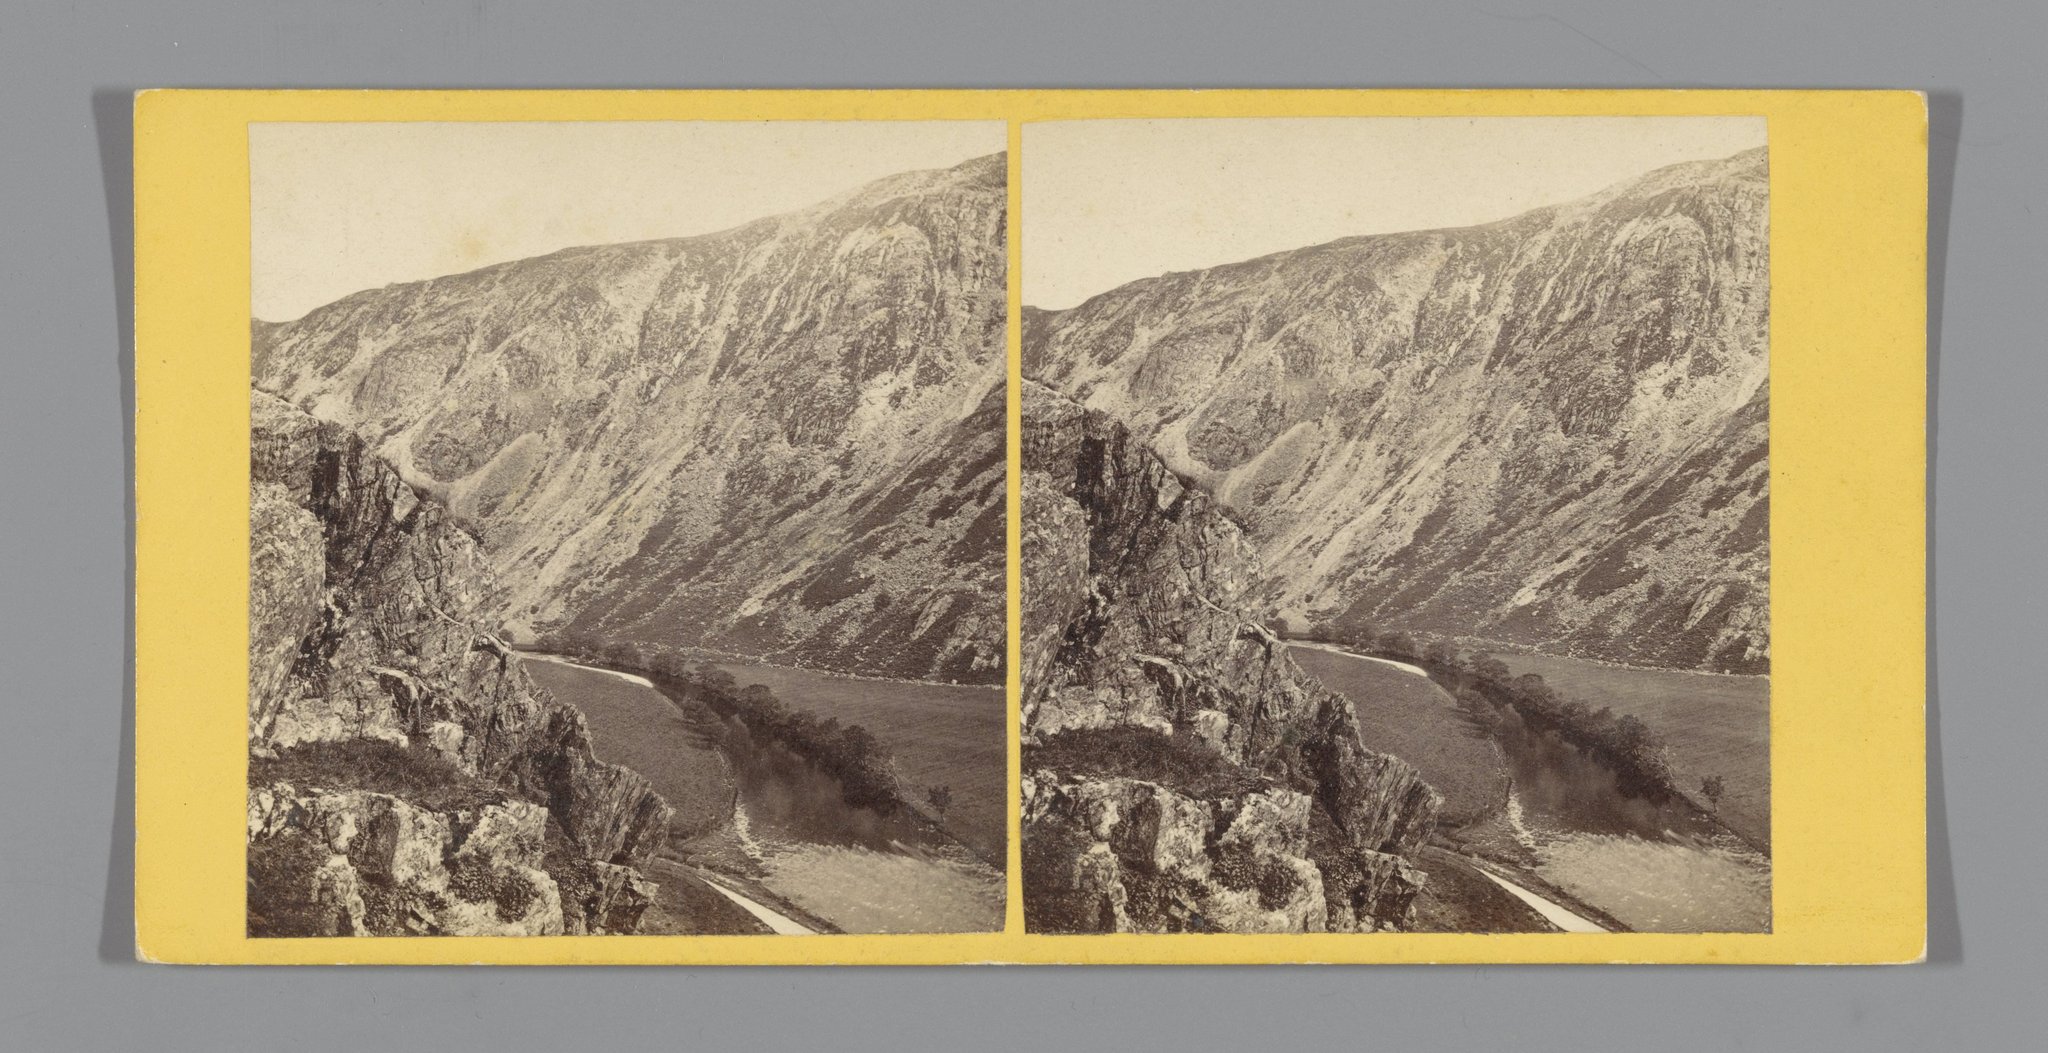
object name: stereograph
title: Gezicht op de Glenalmond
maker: george washington wilson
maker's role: publisher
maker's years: 1823-1893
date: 1850-1880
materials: cardboard, photographic support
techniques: albumen print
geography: glenalmond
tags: dale, valley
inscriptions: number: ‘No. 502.’, name: ‘Registered. G. W. Wilson, Photographer, Aberdeen.’